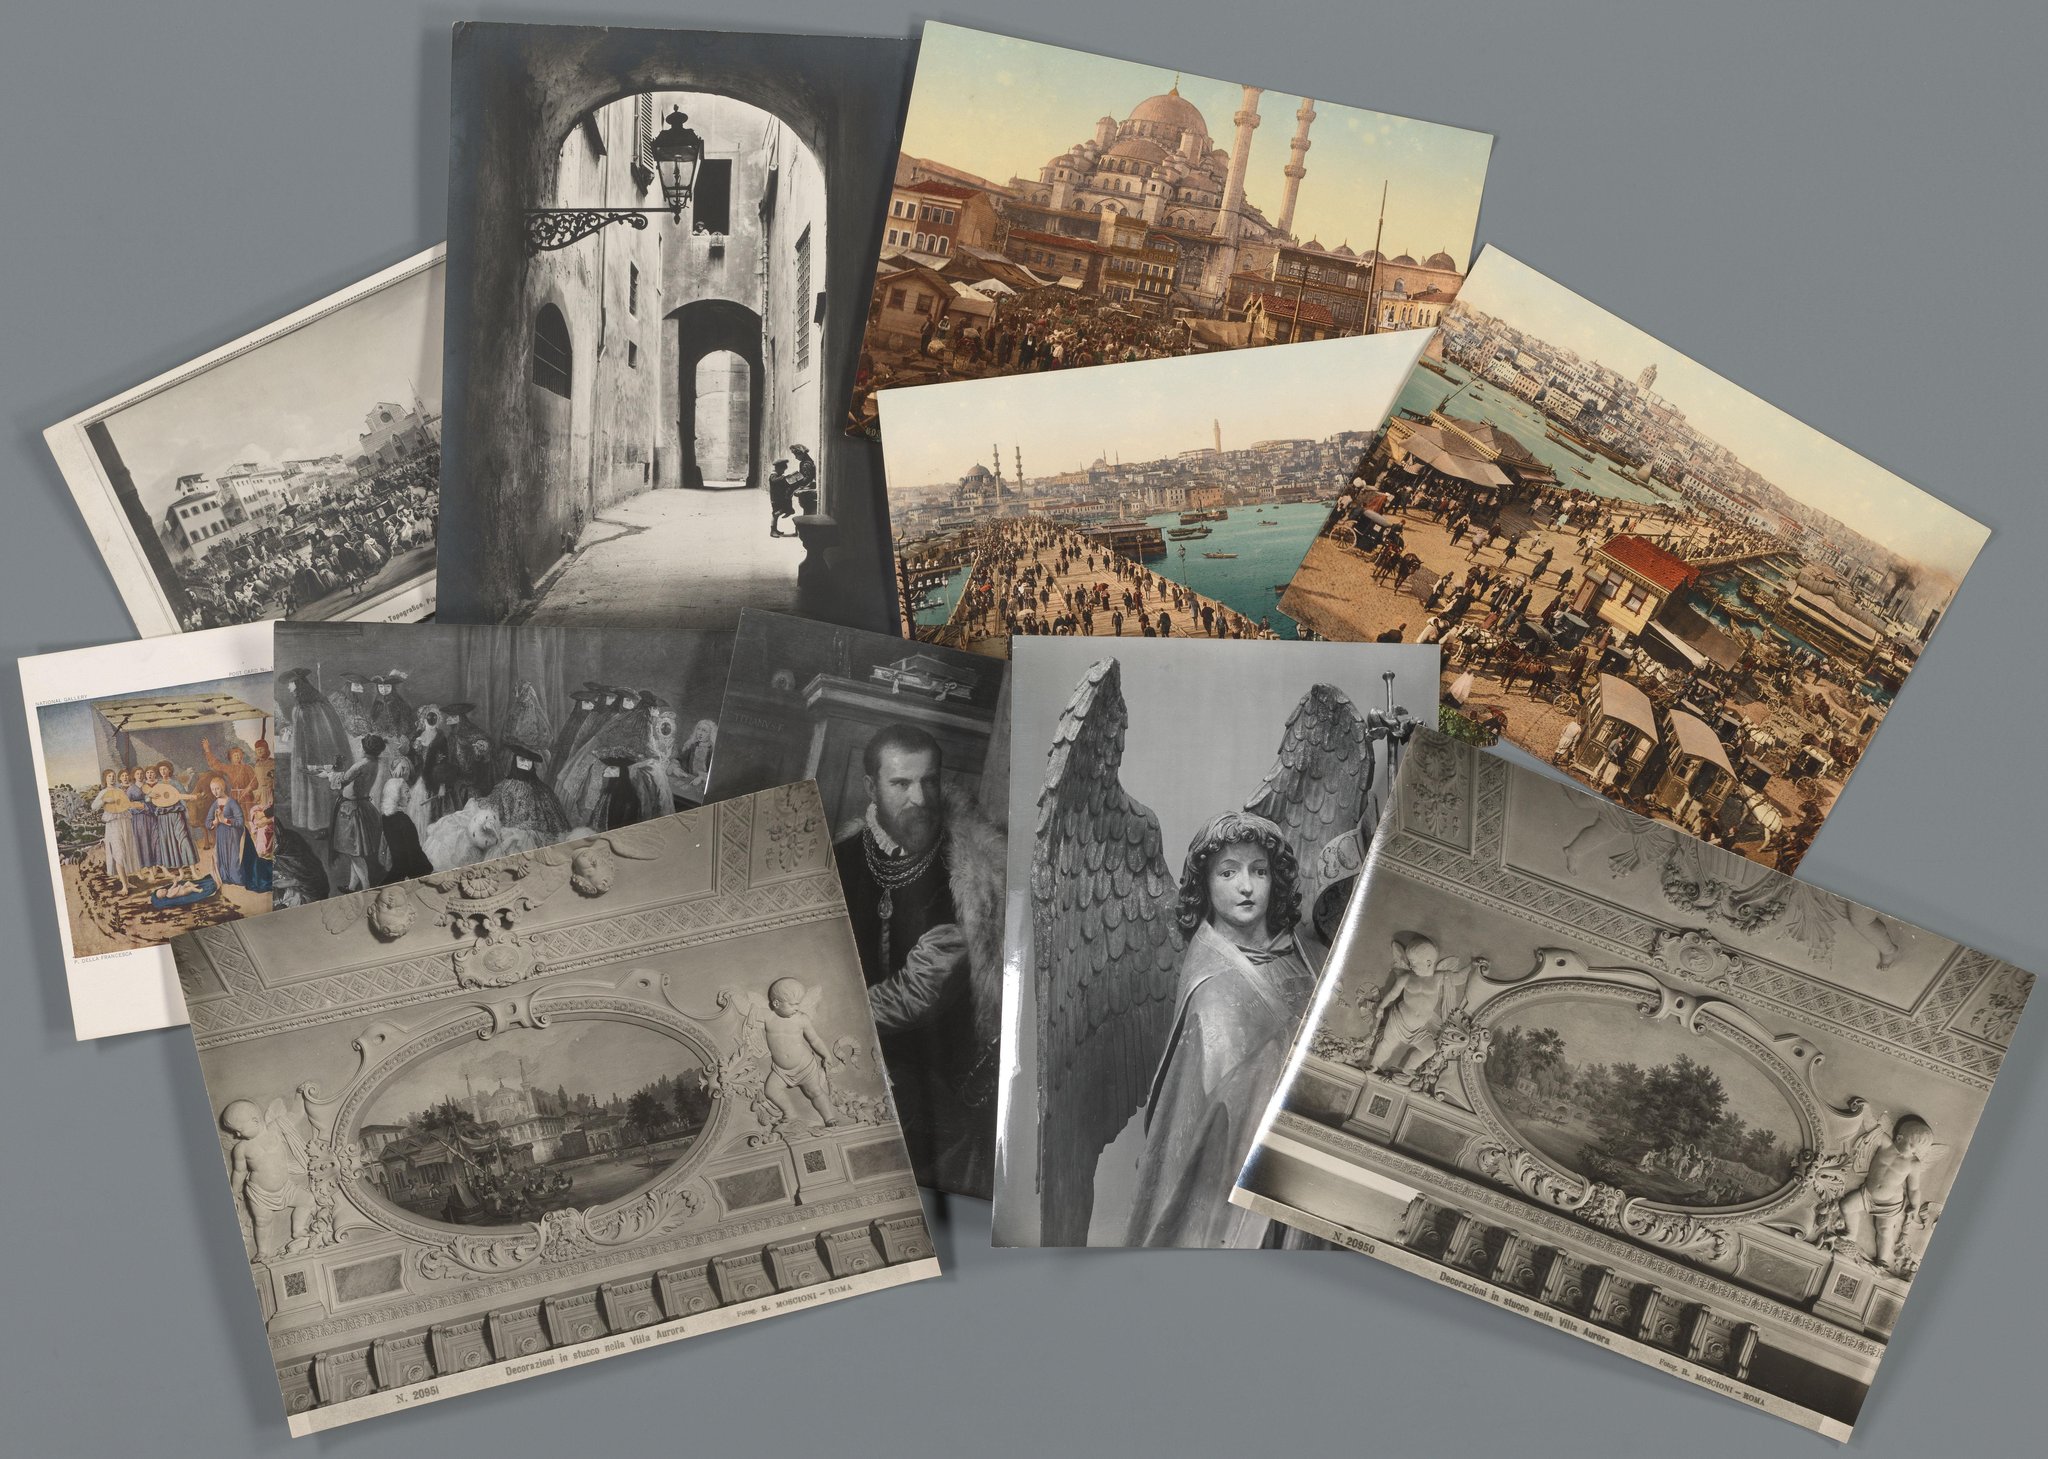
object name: ansichtkaart, prentbriefkaart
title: Fotocollectie van Arthur François Emile van Schendel jr.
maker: arthur françois emile van schendel jr.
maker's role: directeur, kunsthistoricus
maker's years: 1910-1979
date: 1929-1960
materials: paper, cardboard, ink, photographic process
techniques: carbon print, photograph, gelatin silver print, pen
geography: amsterdam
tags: city-view in general; 'veduta', monument, statue, picture, painting, italy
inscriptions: collector's mark: ‘AFE v S’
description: De collectie bevat 116 foto's en 17 fotomechanische afdrukken, gemaakt door professionele fotografen. Het gaat om 57 fotoreproducties van kunstwerken, 43 foto's van Abu Simbel, twintig topografische foto's van Italië en veertien Photochromafdrukken van Constantinopel. Zeven van de topografische foto's zitten in een enveloppe van de fotograaf Francesco Pineider. De meeste objecten hebben het stempel van Van Schendel ('AFE v S') en handgeschreven notities op verso. Er zitten ook enkele bladen met aantekeningen en correspondentie bij.